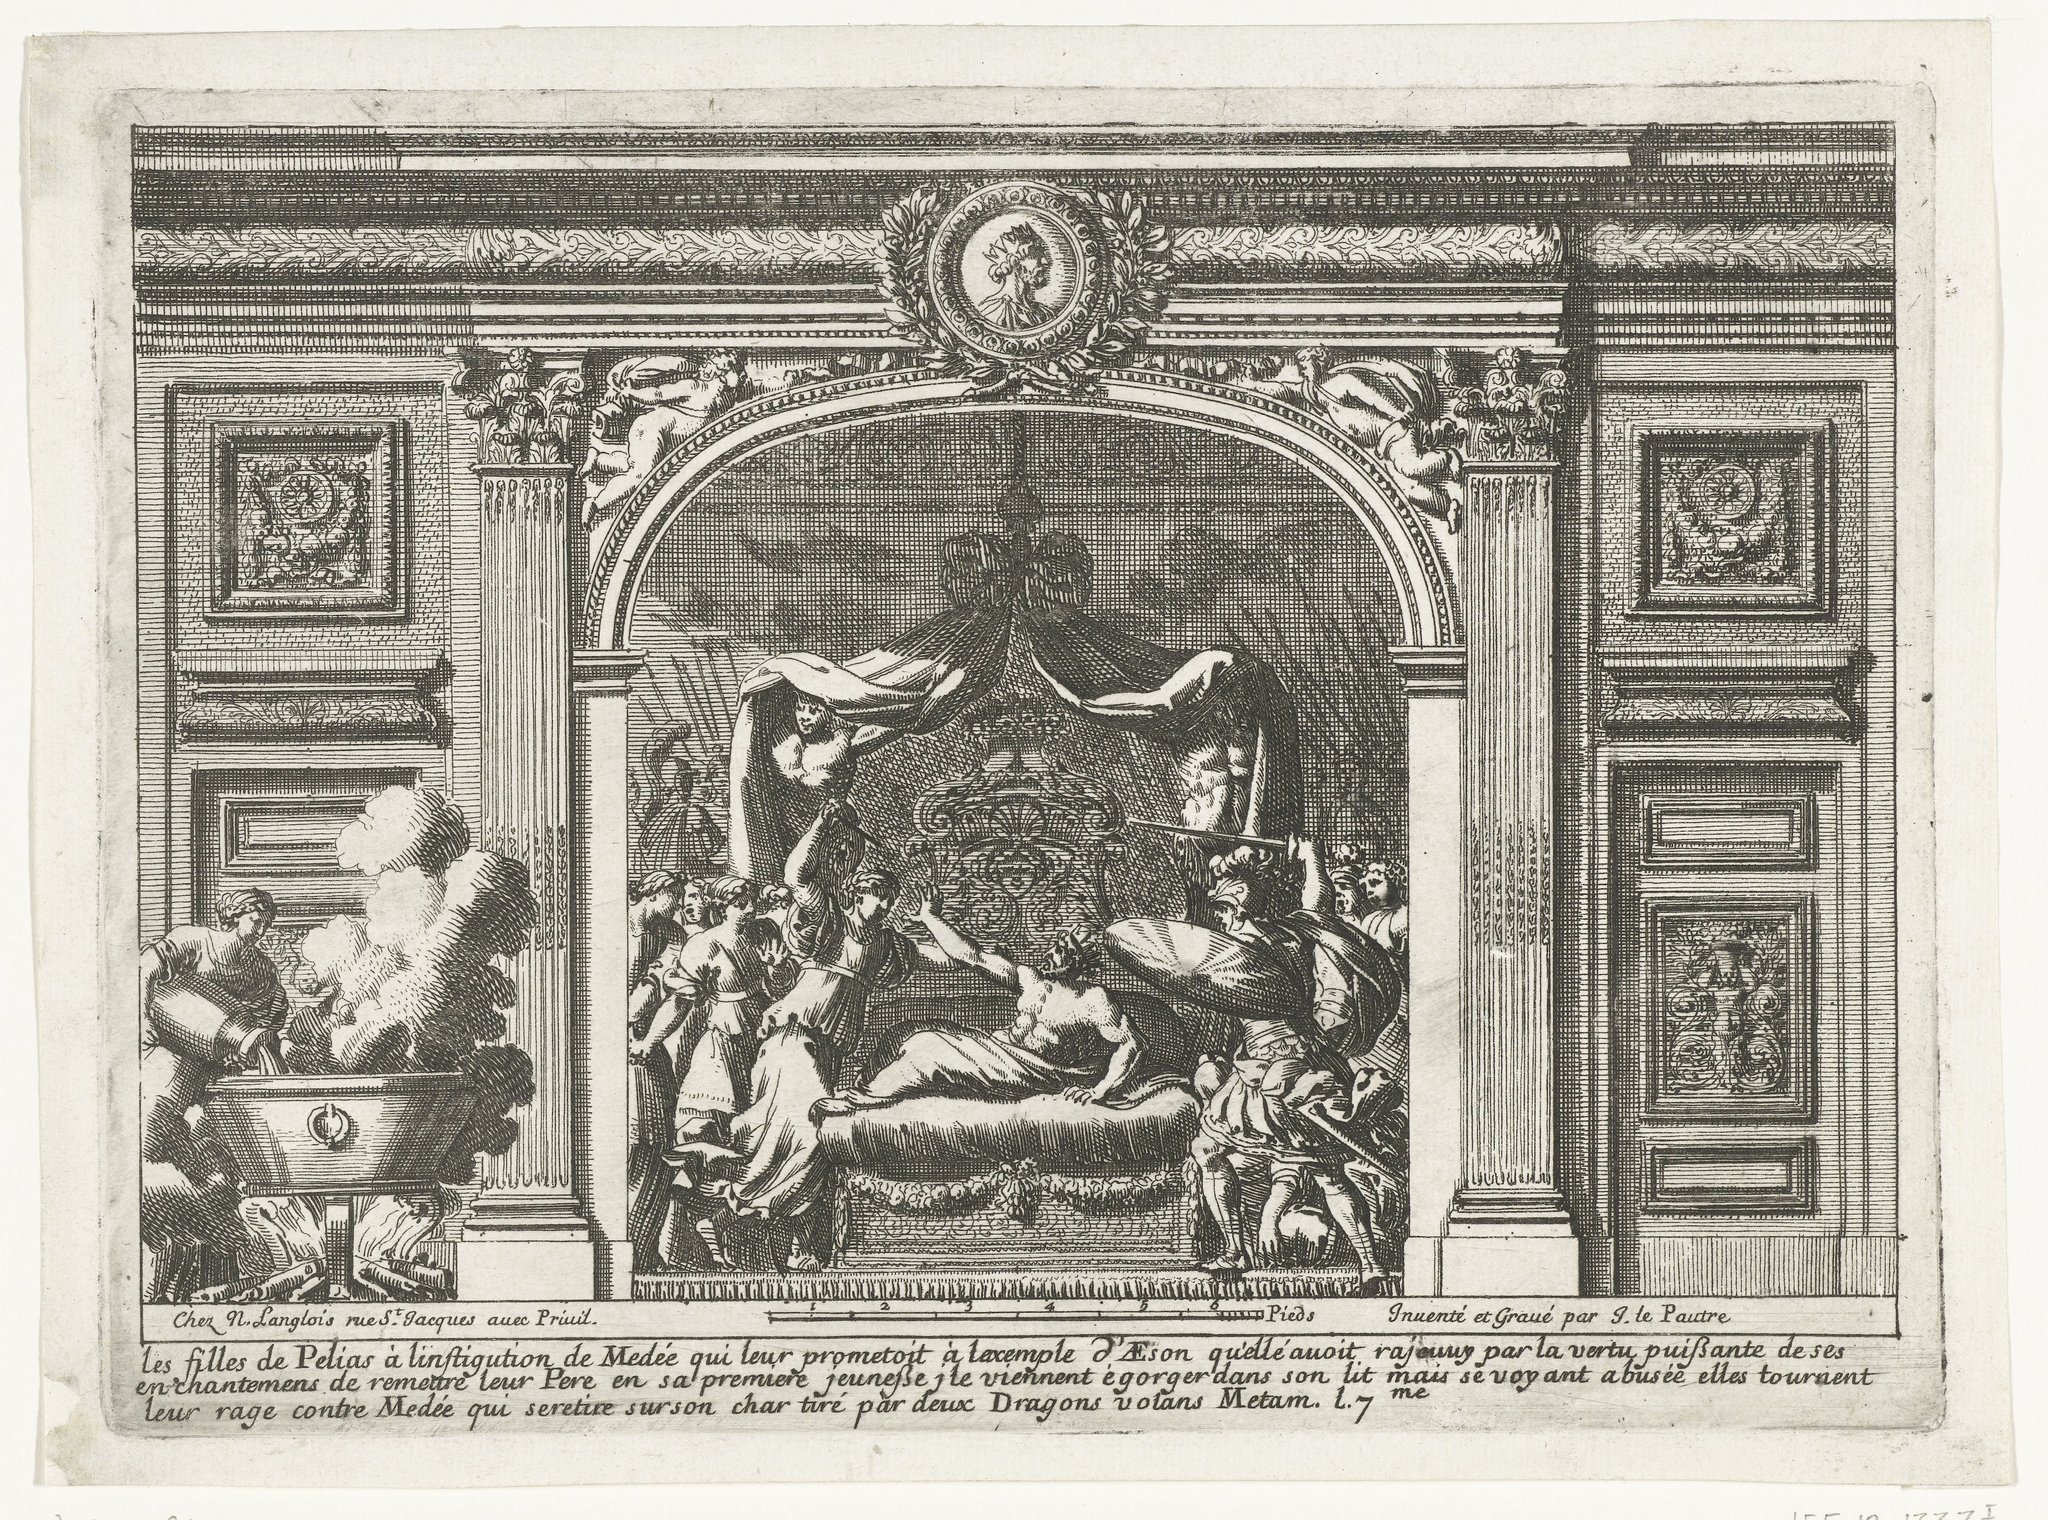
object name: print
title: Alkoof met Pelias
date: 1662-1670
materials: paper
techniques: etching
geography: france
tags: the daughters of pelias kill their father in his bed; medea plunges his body in boiling water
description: Pelias wordt vermoord door zijn dochters. Onderaan staan drie regels tekst. Uit serie van 6 bladen.